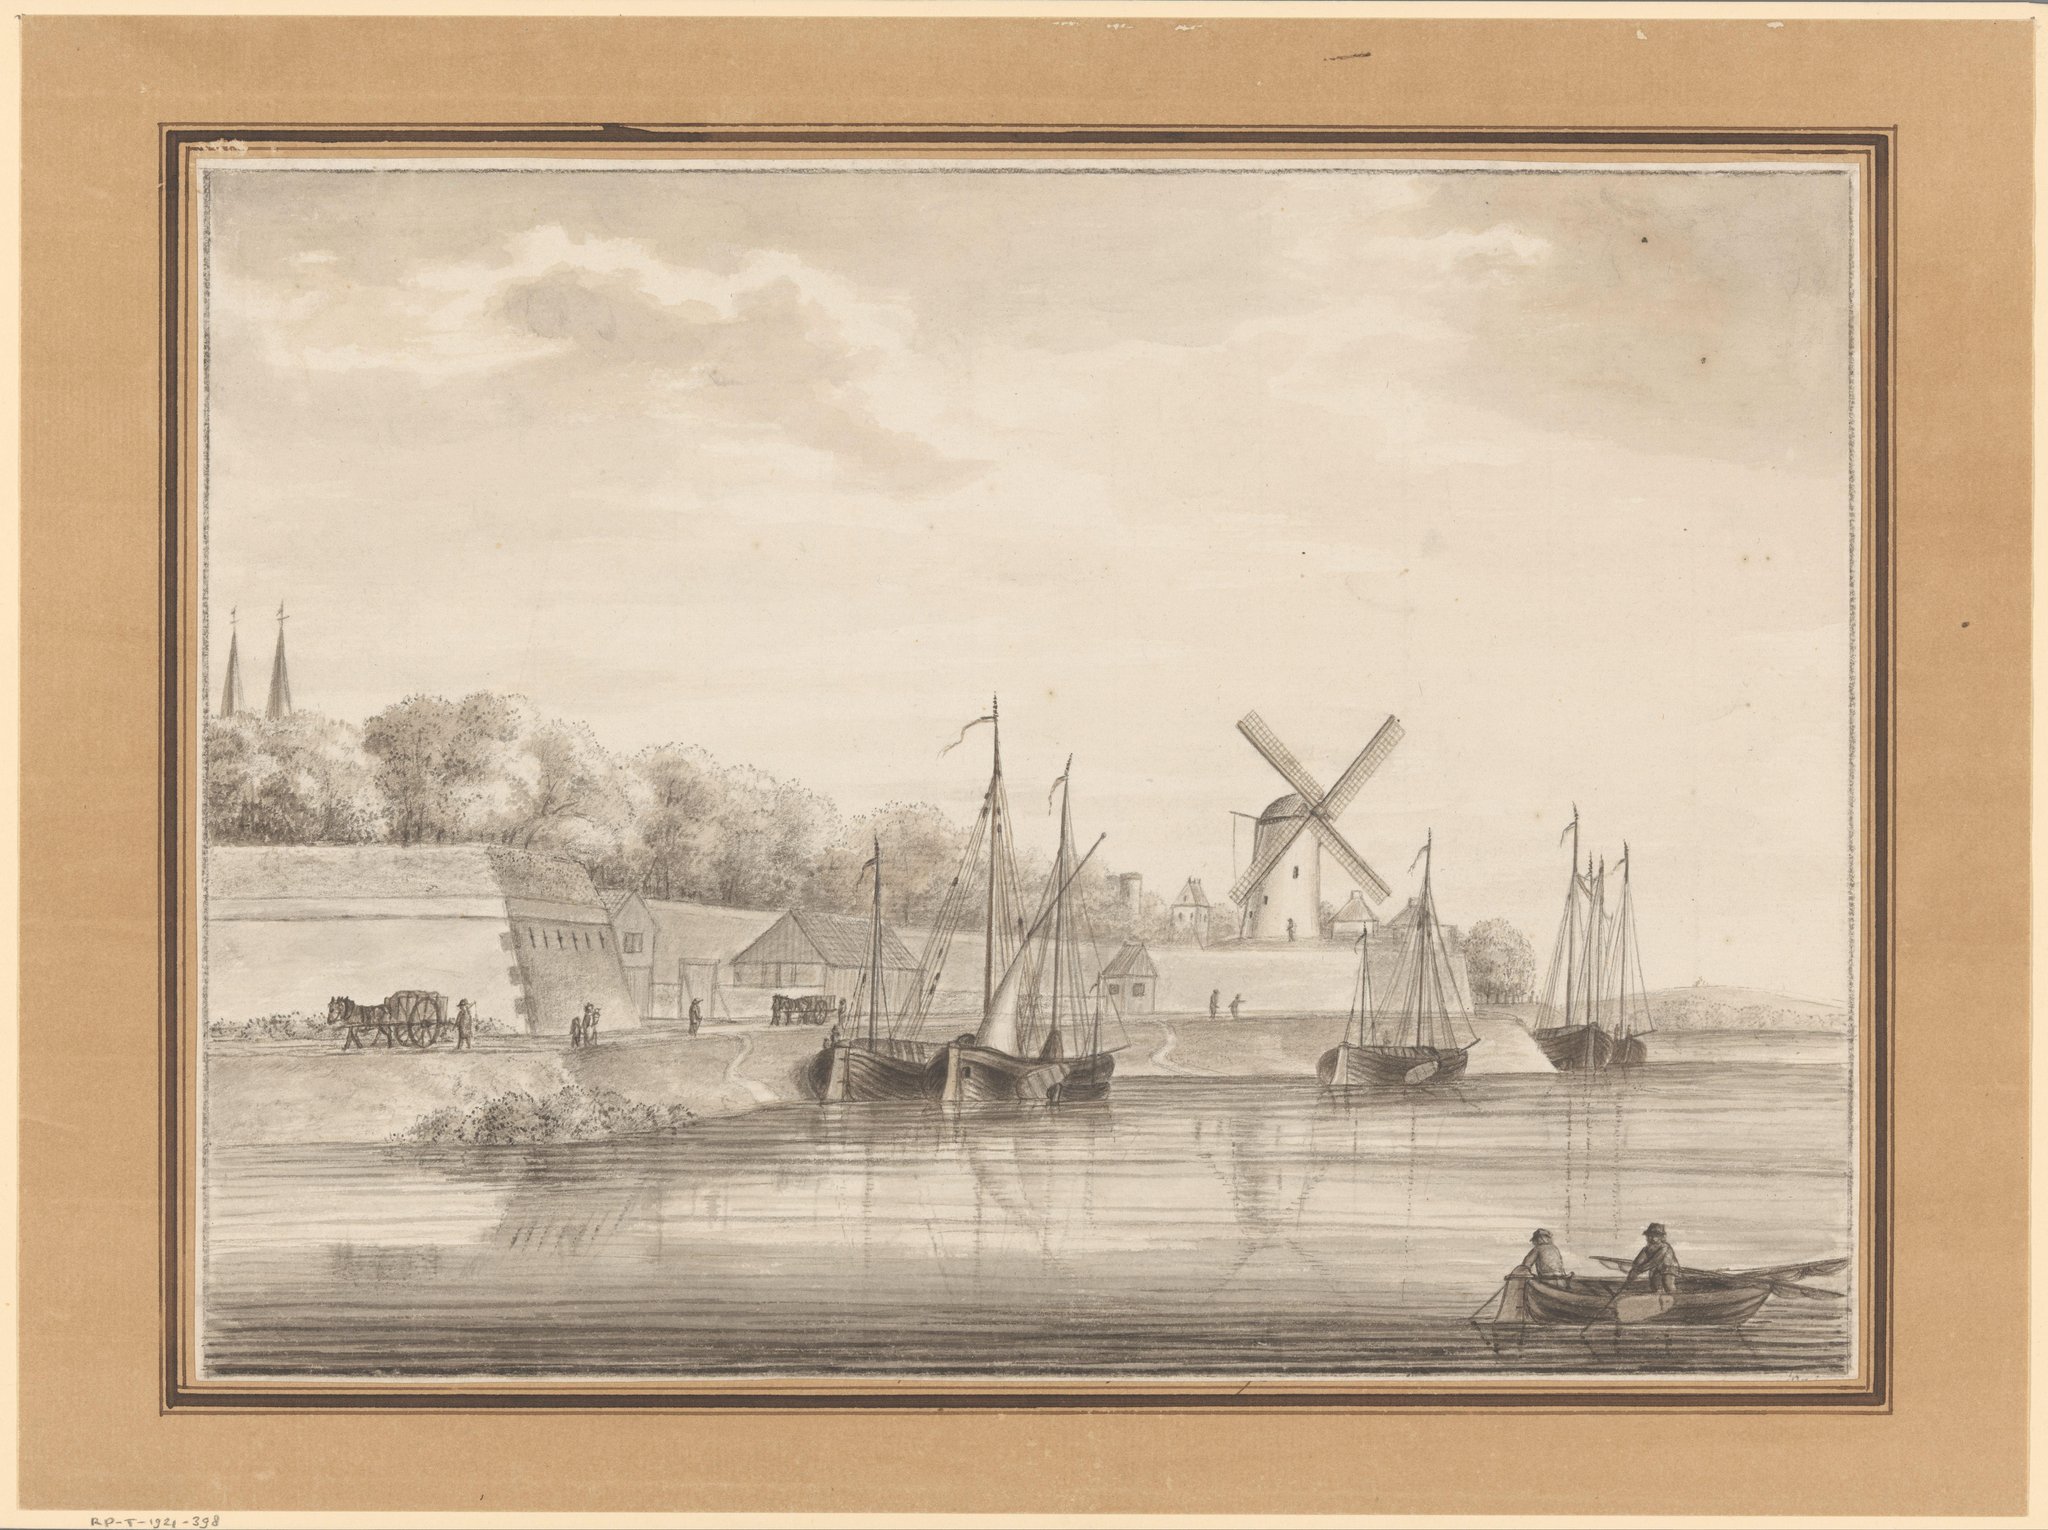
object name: drawing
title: Gezicht op de Rijn bij Arnhem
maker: Anonymous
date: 1795-1805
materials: ink, paper, pigment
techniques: brush, pen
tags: river, pier, quay, wharf, windmill, arnhem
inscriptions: collector's mark: Lugt 2233, inscription: ‘1801’, inscription: ‘Gezicht op de Rhijn langs Arnhem. 1798’